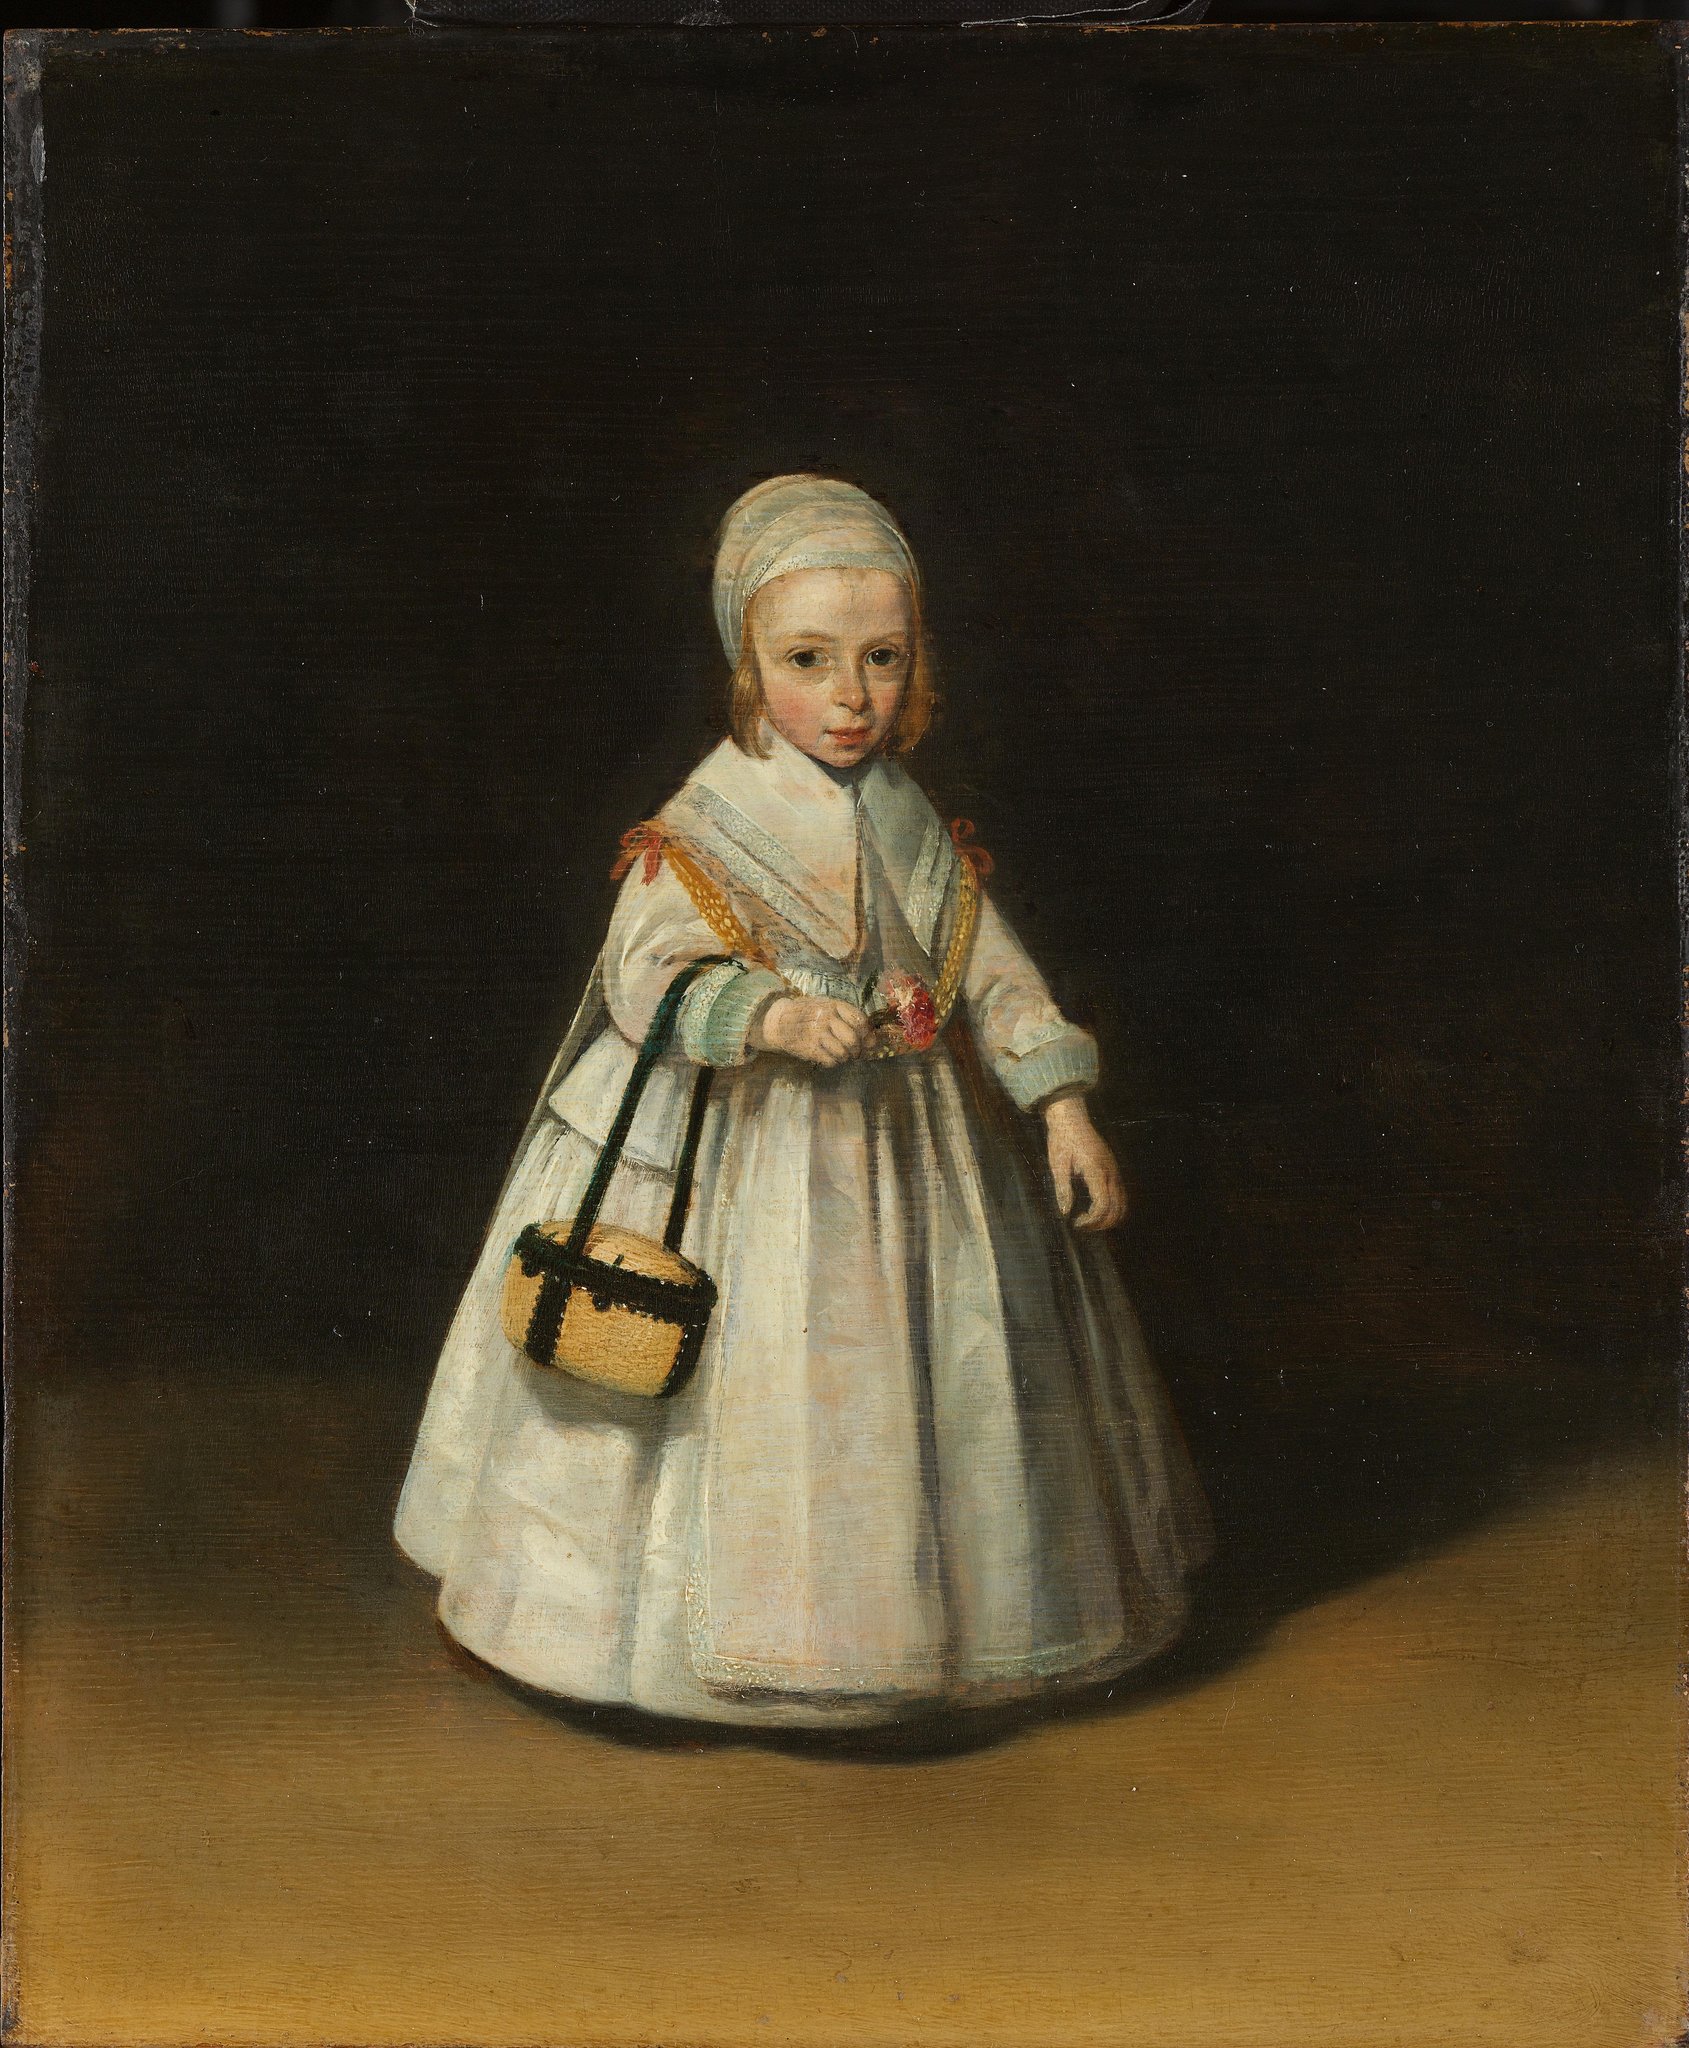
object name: painting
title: Portrait of Helena van der Schalcke (1646-1671)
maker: gerard ter borch (ii)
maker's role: draughtsman, painter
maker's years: 1617-1681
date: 1648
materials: oil, panel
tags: haarlem, historical persons - bb - woman, toddler - aa - girl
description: Helena van der Schalck, a merchant's daughter was no more than three years old when she was portrayed here. Her silk dress adorned with bows and her straw purse resemble adult attire. However, just visible on her back is a bit of her walking reins, used to keep children safe. The red carnation in her hand symbolizes hope for eternal life. Sadly, Helena died at the age of 24.